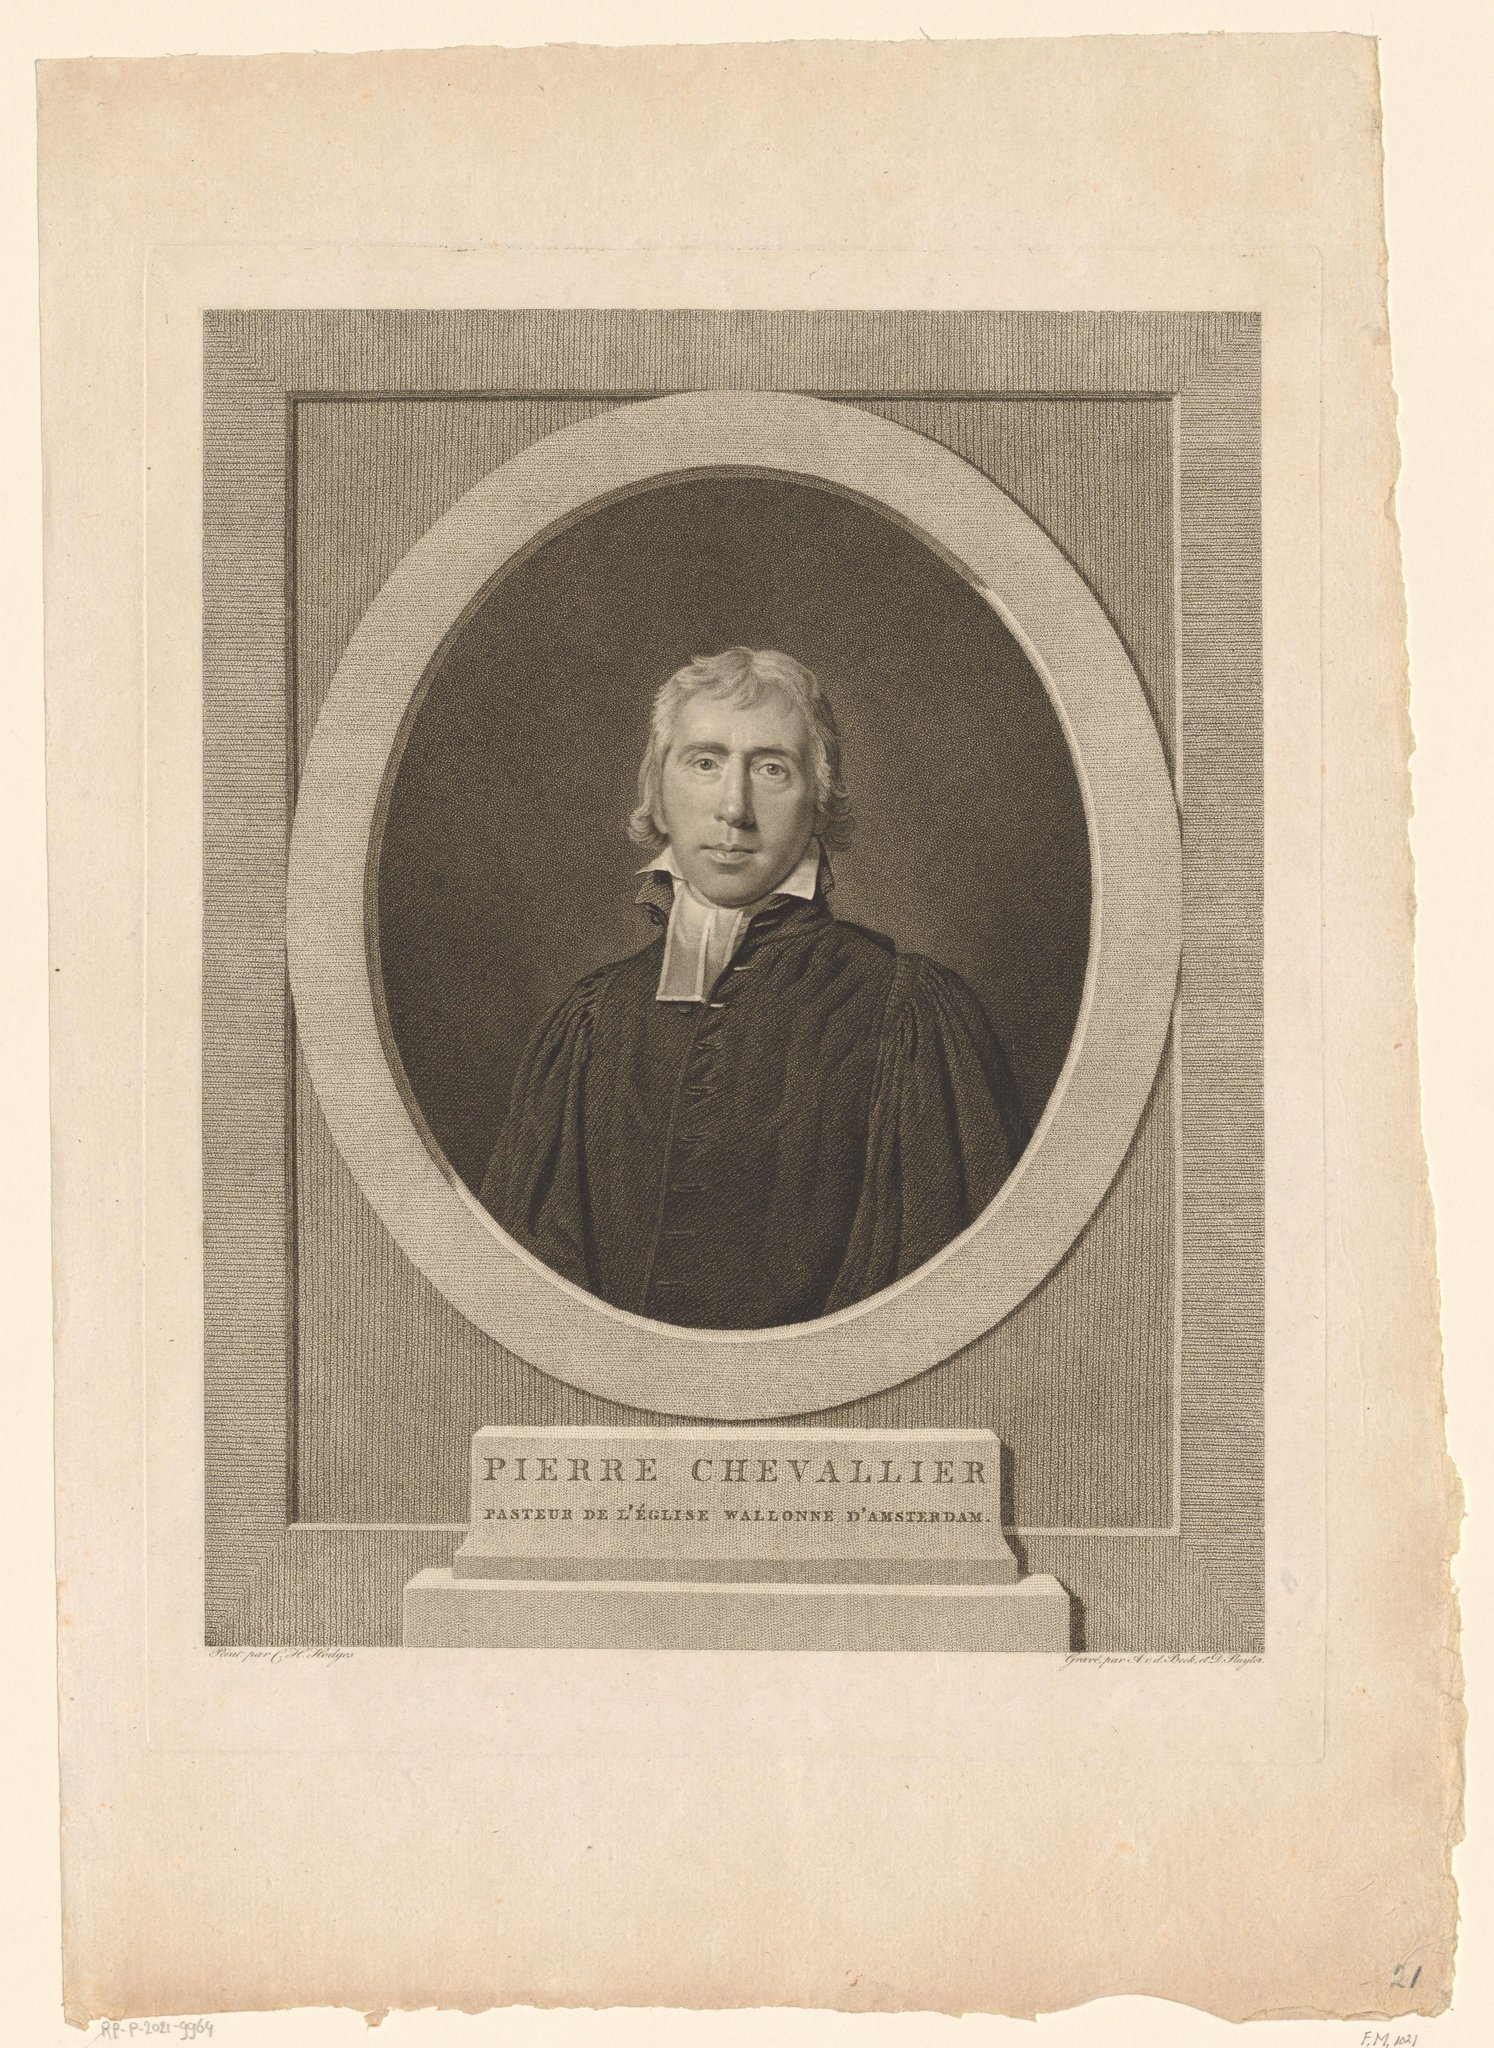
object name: print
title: Portret van Petrus Chevallier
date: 1805-1852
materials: paper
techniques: engraving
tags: groningen (province), amsterdam, historical persons